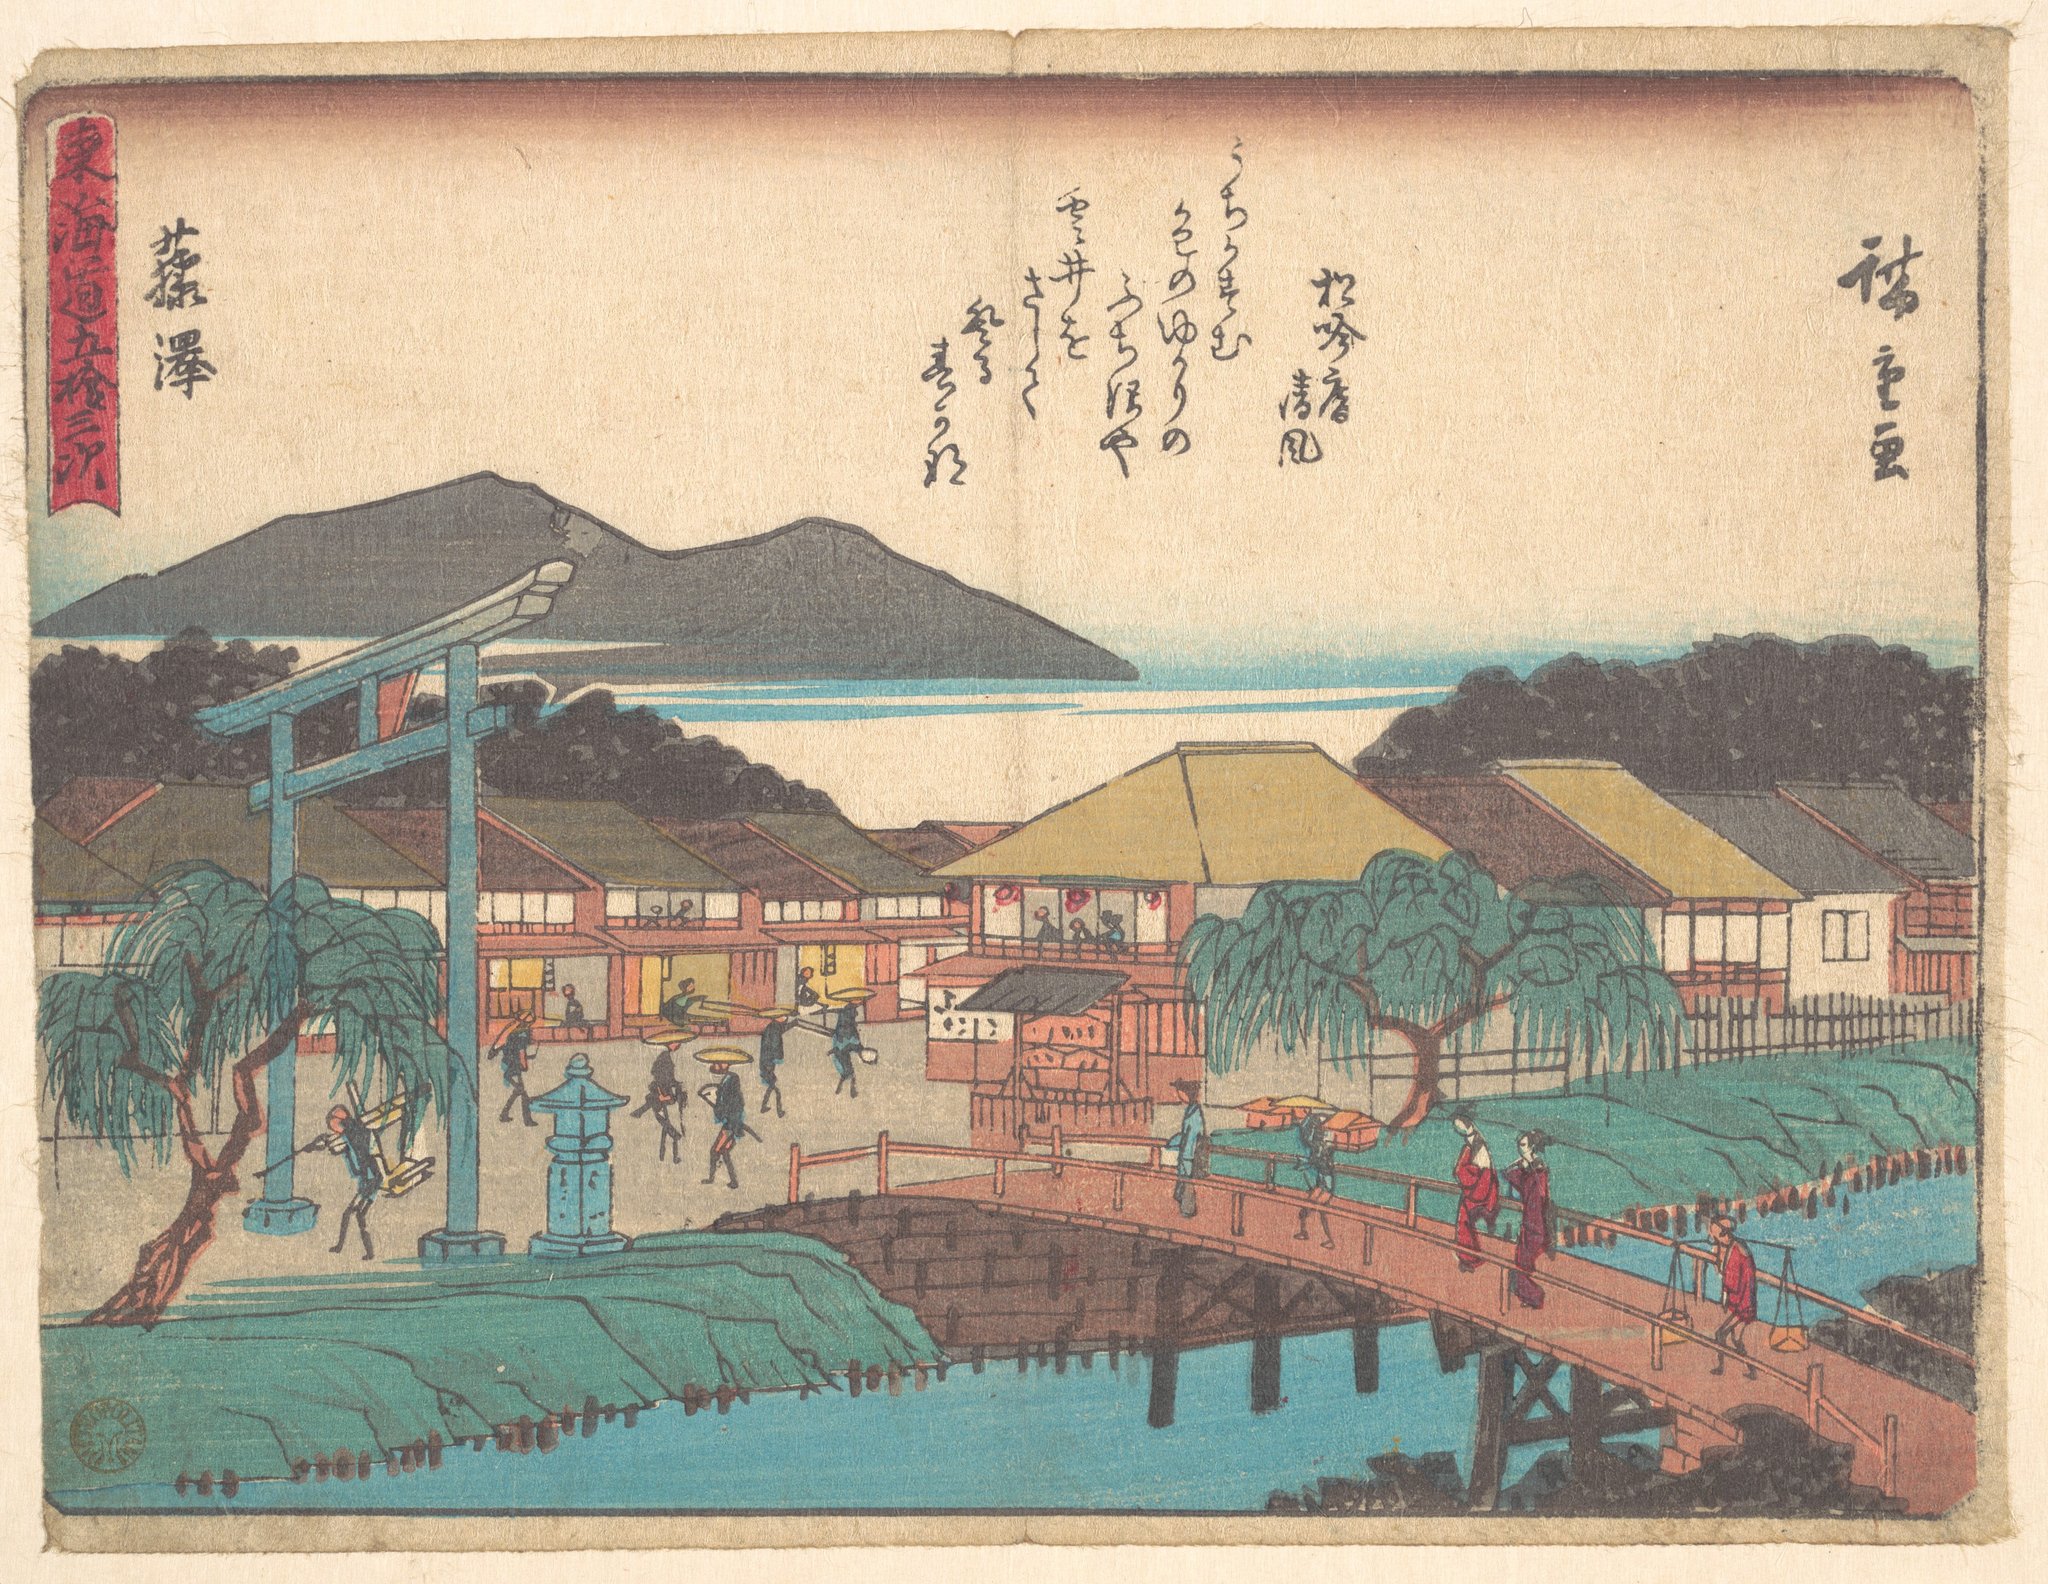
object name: print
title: Fujisawa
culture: japanese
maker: utagawa hiroshige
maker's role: artist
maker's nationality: japanese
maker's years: 1797-1858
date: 1838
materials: ink, paper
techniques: woodblock print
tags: human figures,houses,bridges,mountains